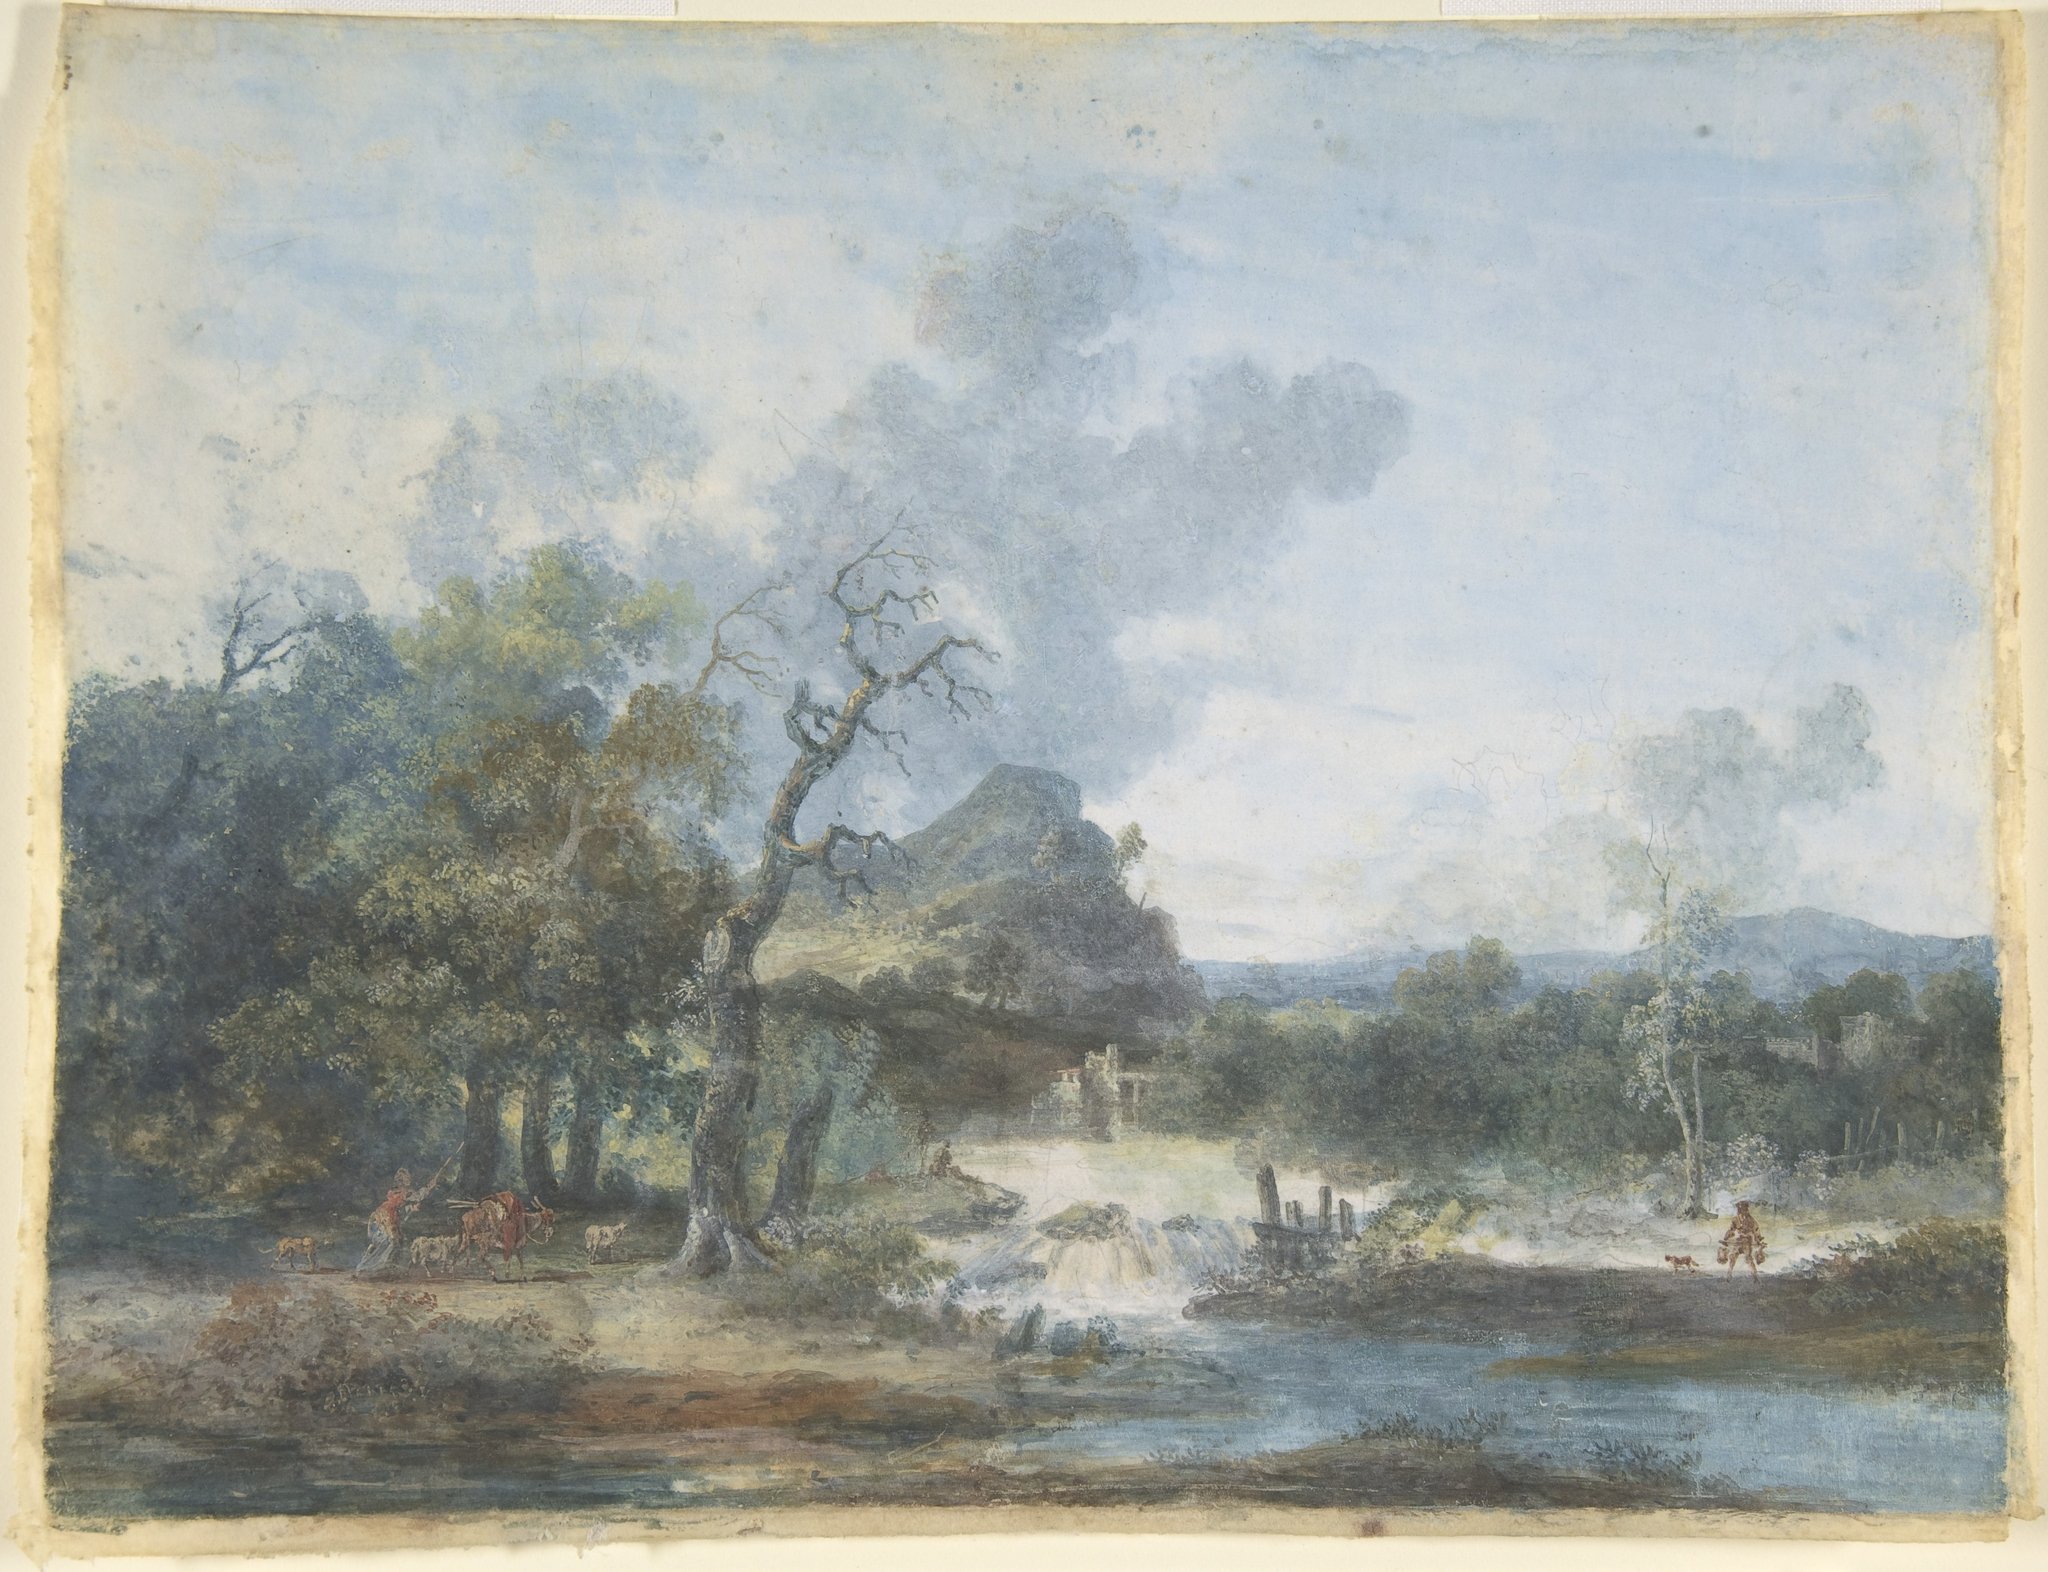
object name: drawing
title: Shepherdess near a Waterfall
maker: louis gabriel moreau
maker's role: artist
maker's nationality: french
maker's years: 1740-1806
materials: gouache, graphite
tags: women,waterfalls,trees,shepherds